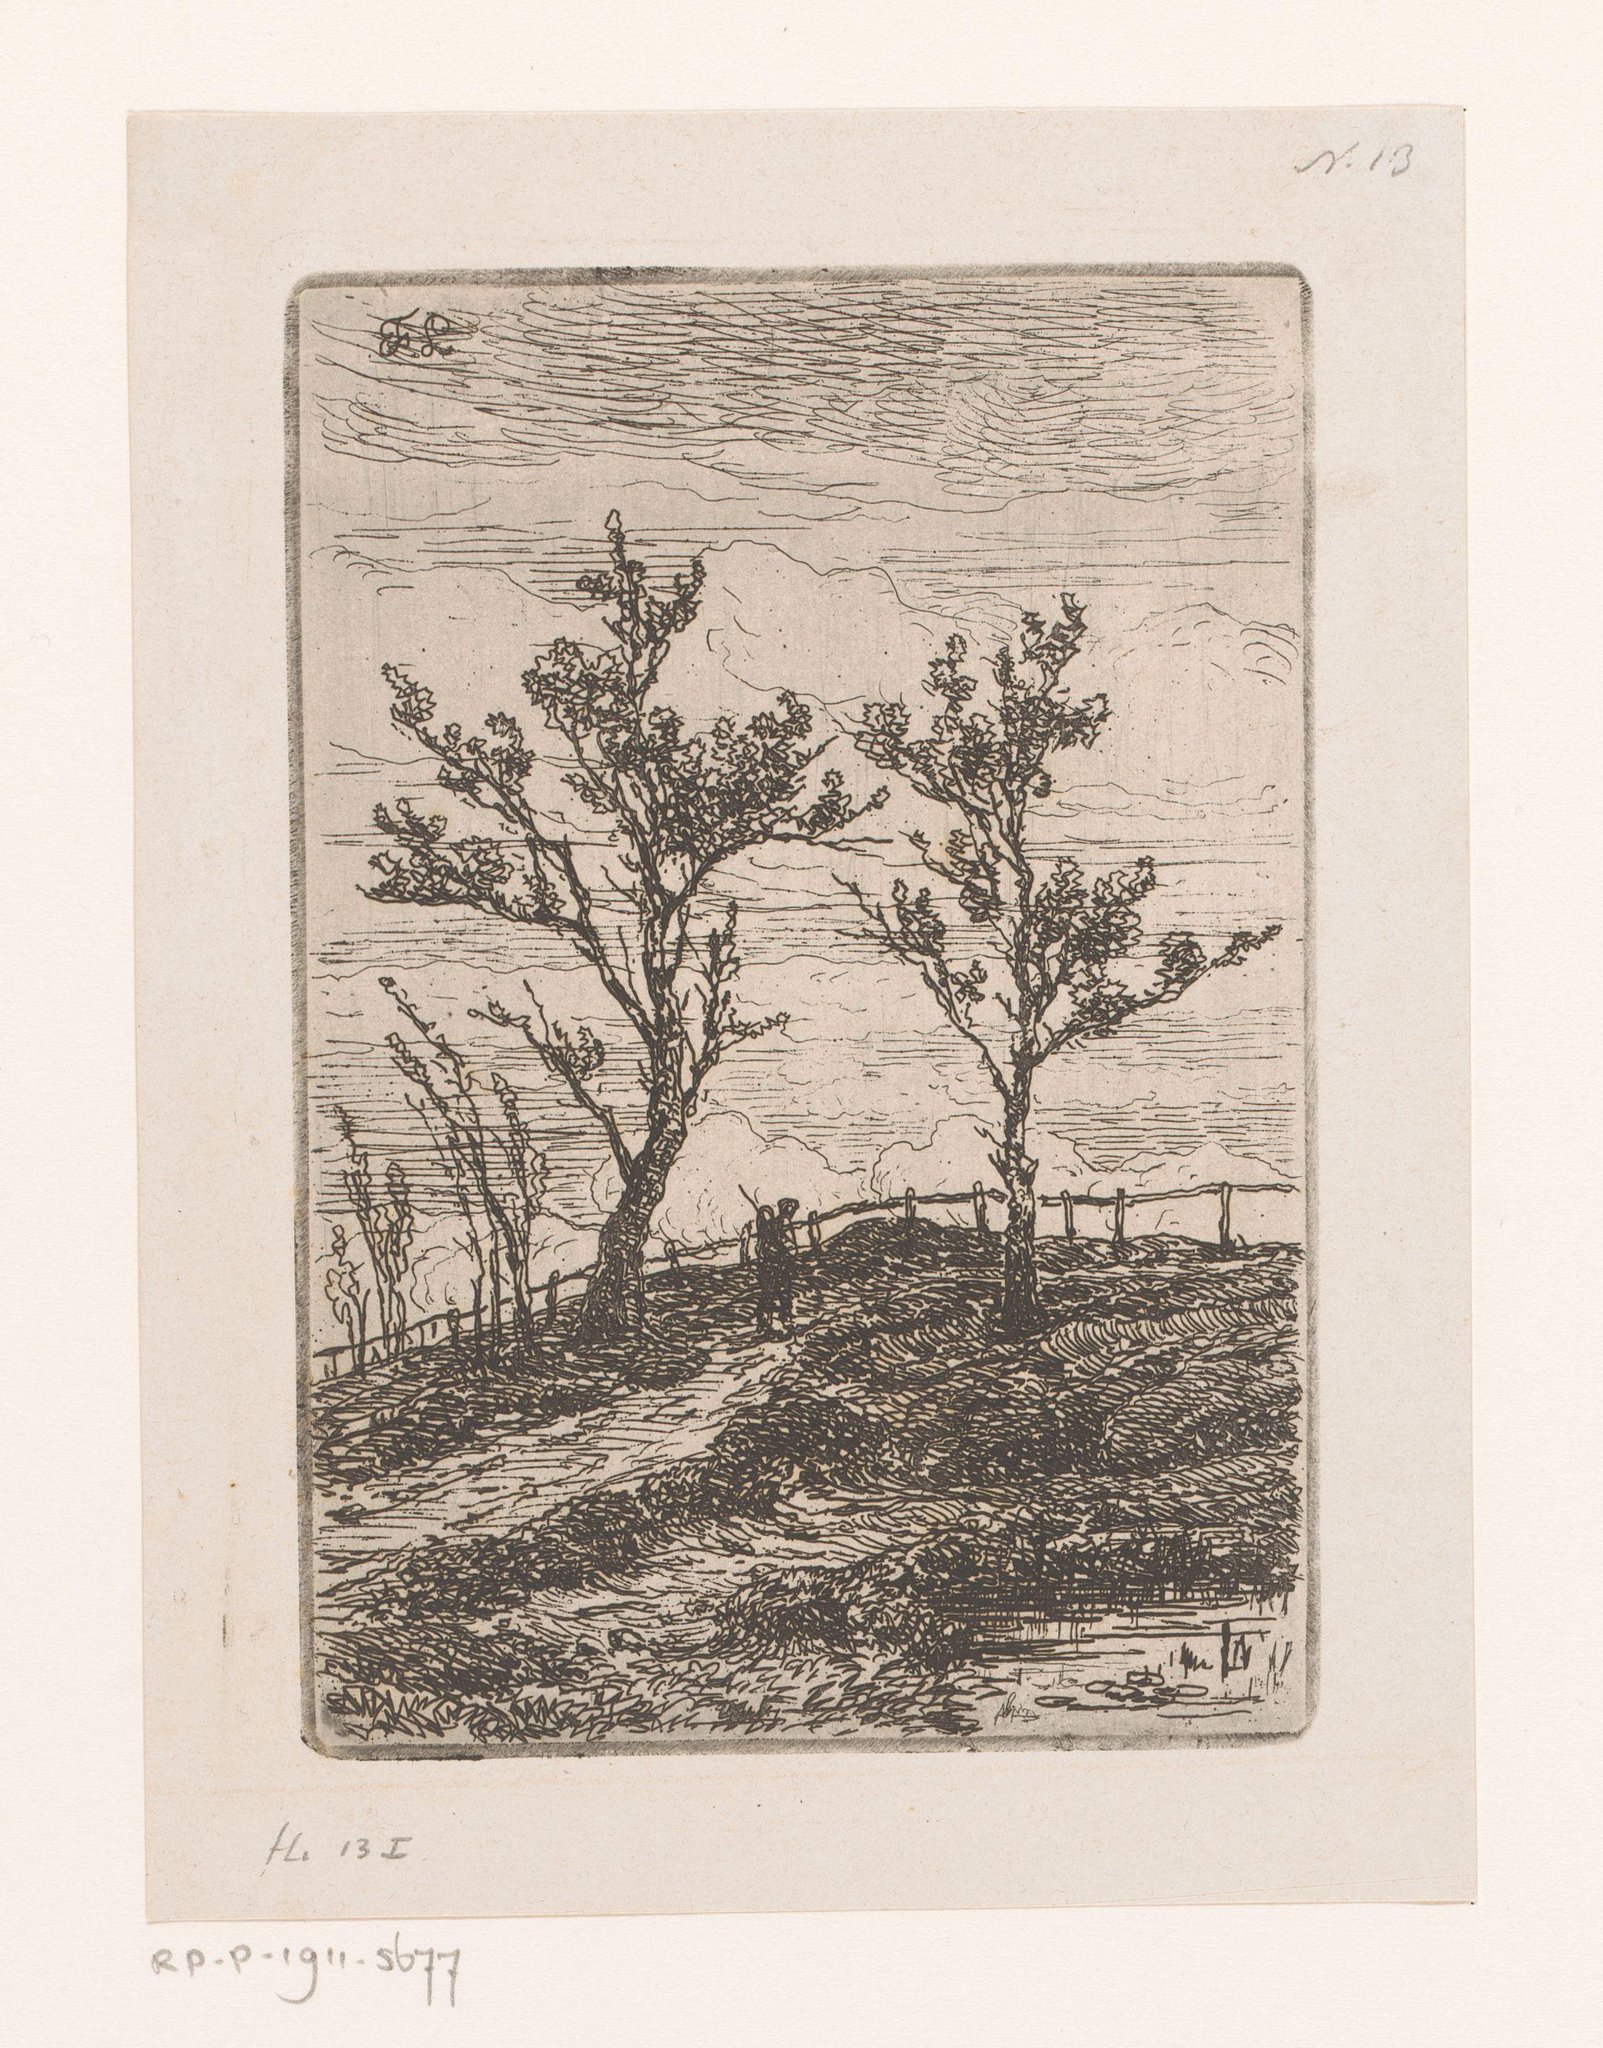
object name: print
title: Eenzame wandelaar in een landschap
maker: jean pierre françois lamorinière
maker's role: print maker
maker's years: 1828-1911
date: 1838-1911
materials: paper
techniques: etching, intaglio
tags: walking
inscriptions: collector's mark: Lugt 1485, collector's mark: Lugt 2228